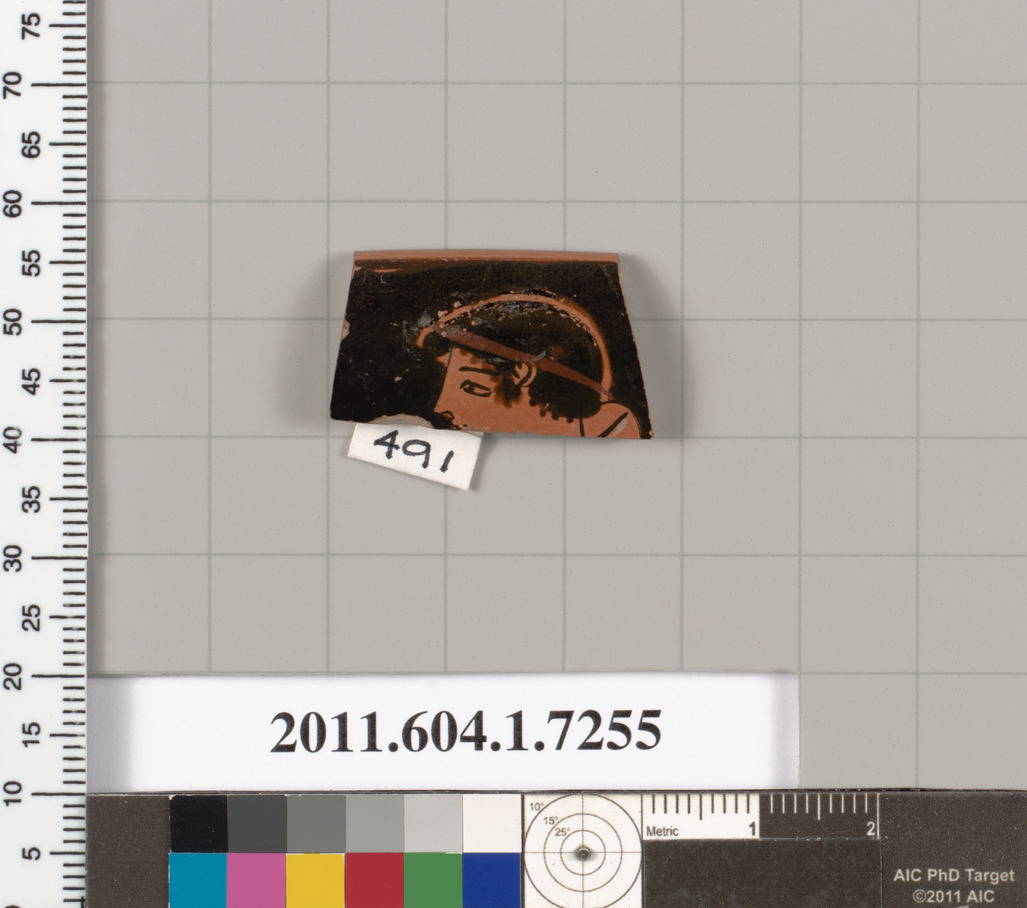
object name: kylix fragment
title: Terracotta rim fragment of a kylix (drinking cup)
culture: greek, attic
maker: makron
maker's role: artist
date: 500-480 BCE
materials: terracotta